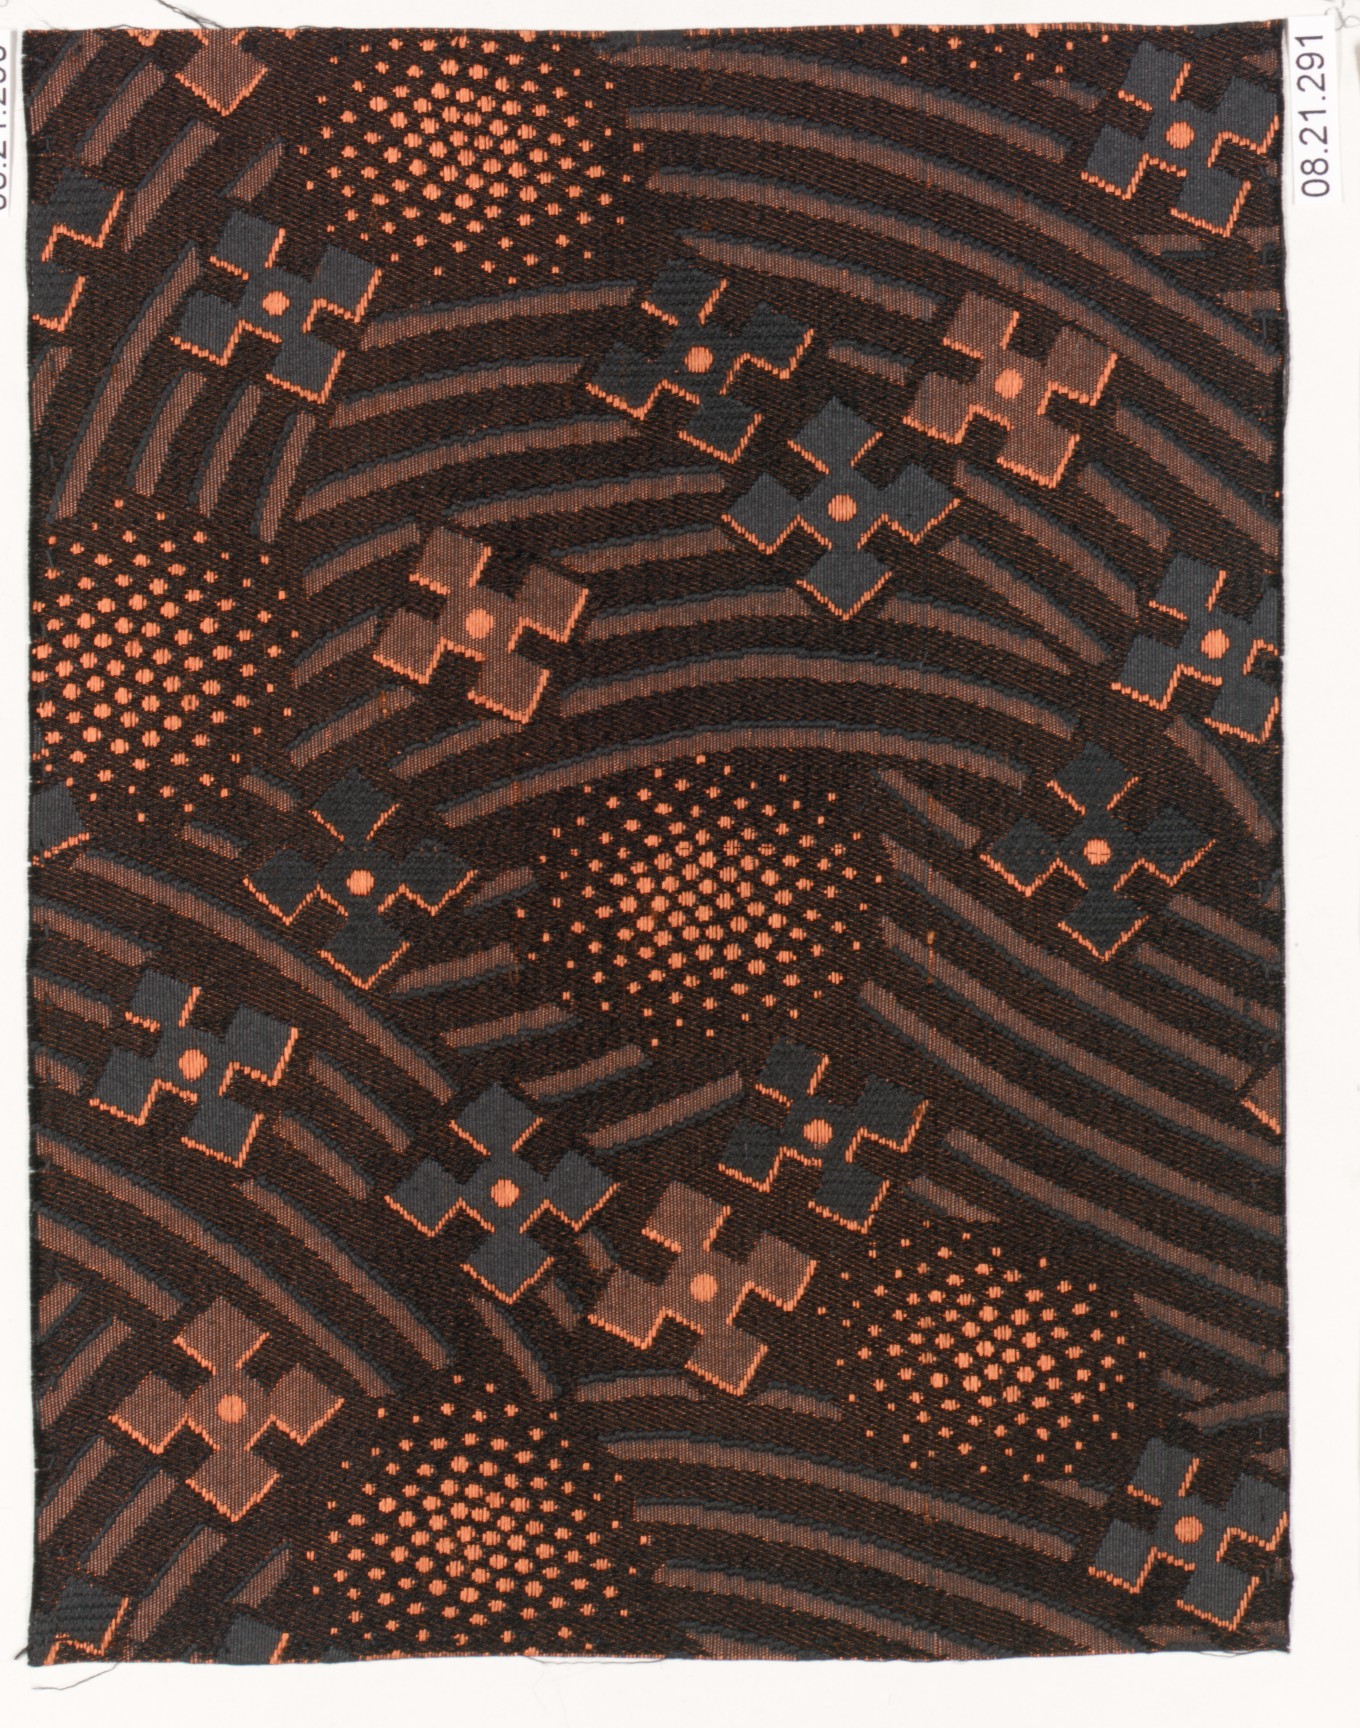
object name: textile sample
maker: Anonymous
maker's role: designer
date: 1900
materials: silk